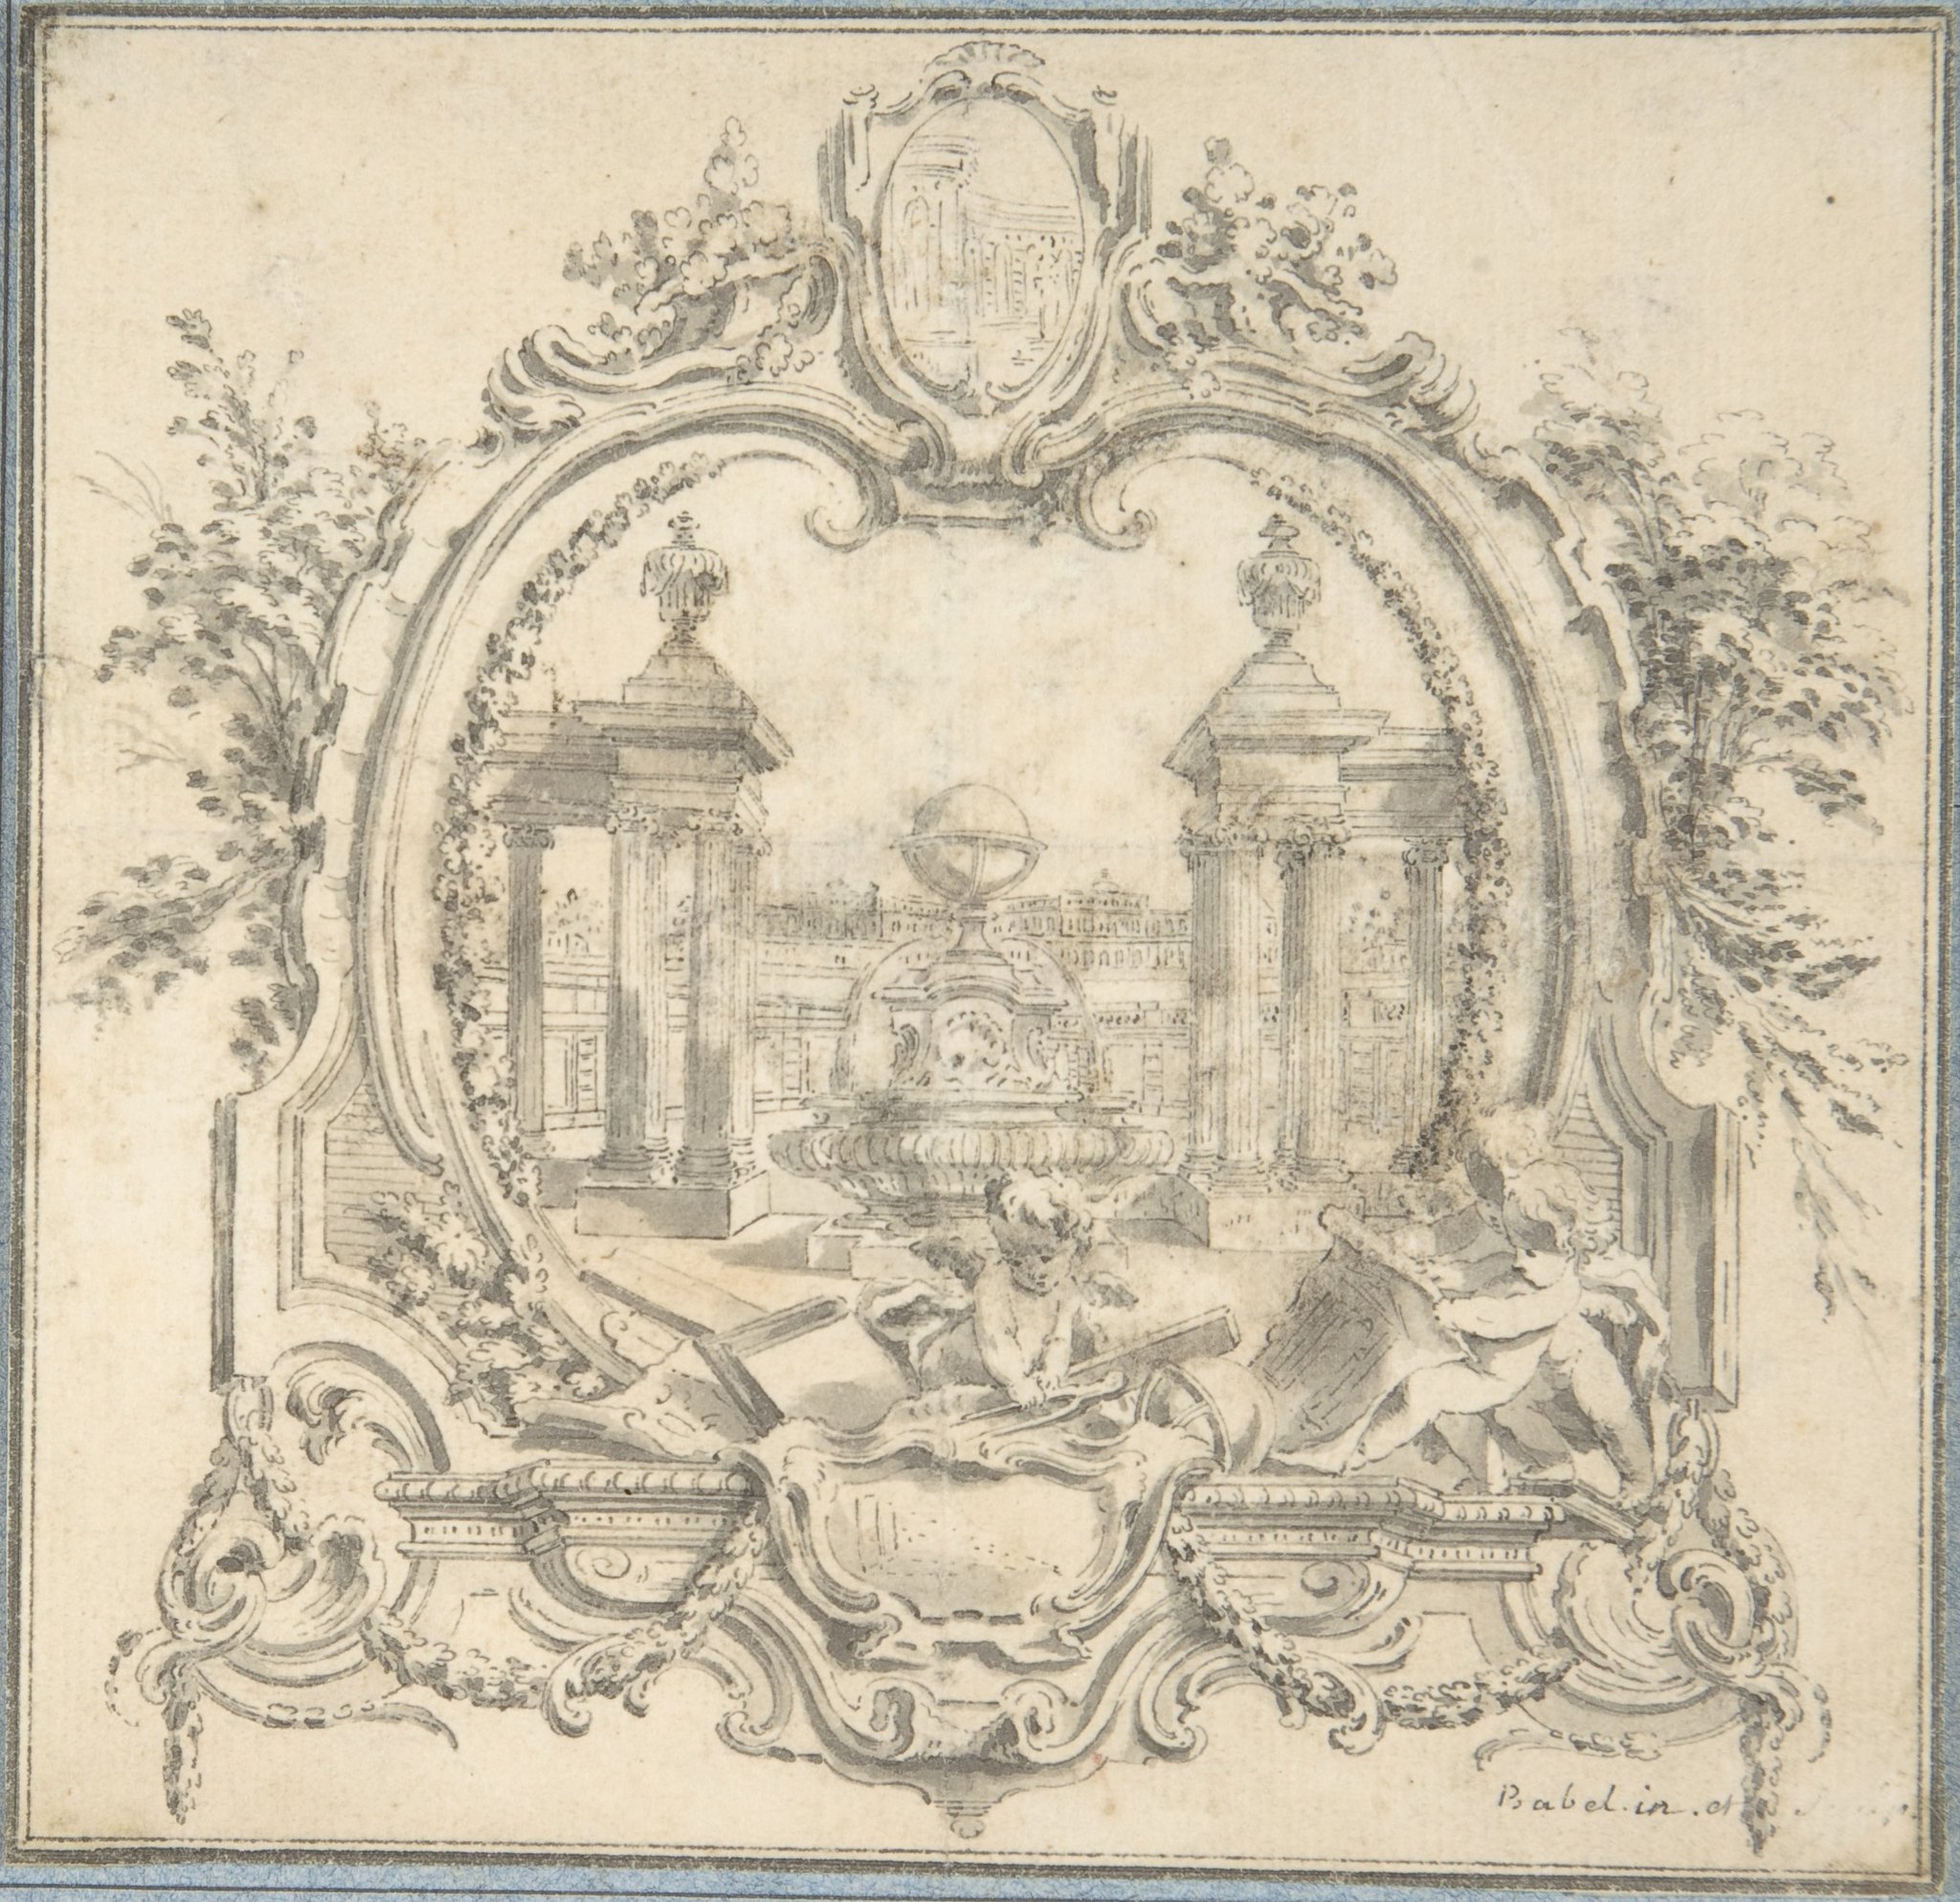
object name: book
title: Study for a Book Vignette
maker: pierre edmé babel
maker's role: artist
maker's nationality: french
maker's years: 1720-1775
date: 1701-1800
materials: ink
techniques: brush, pen, wash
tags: gates,garlands,putti